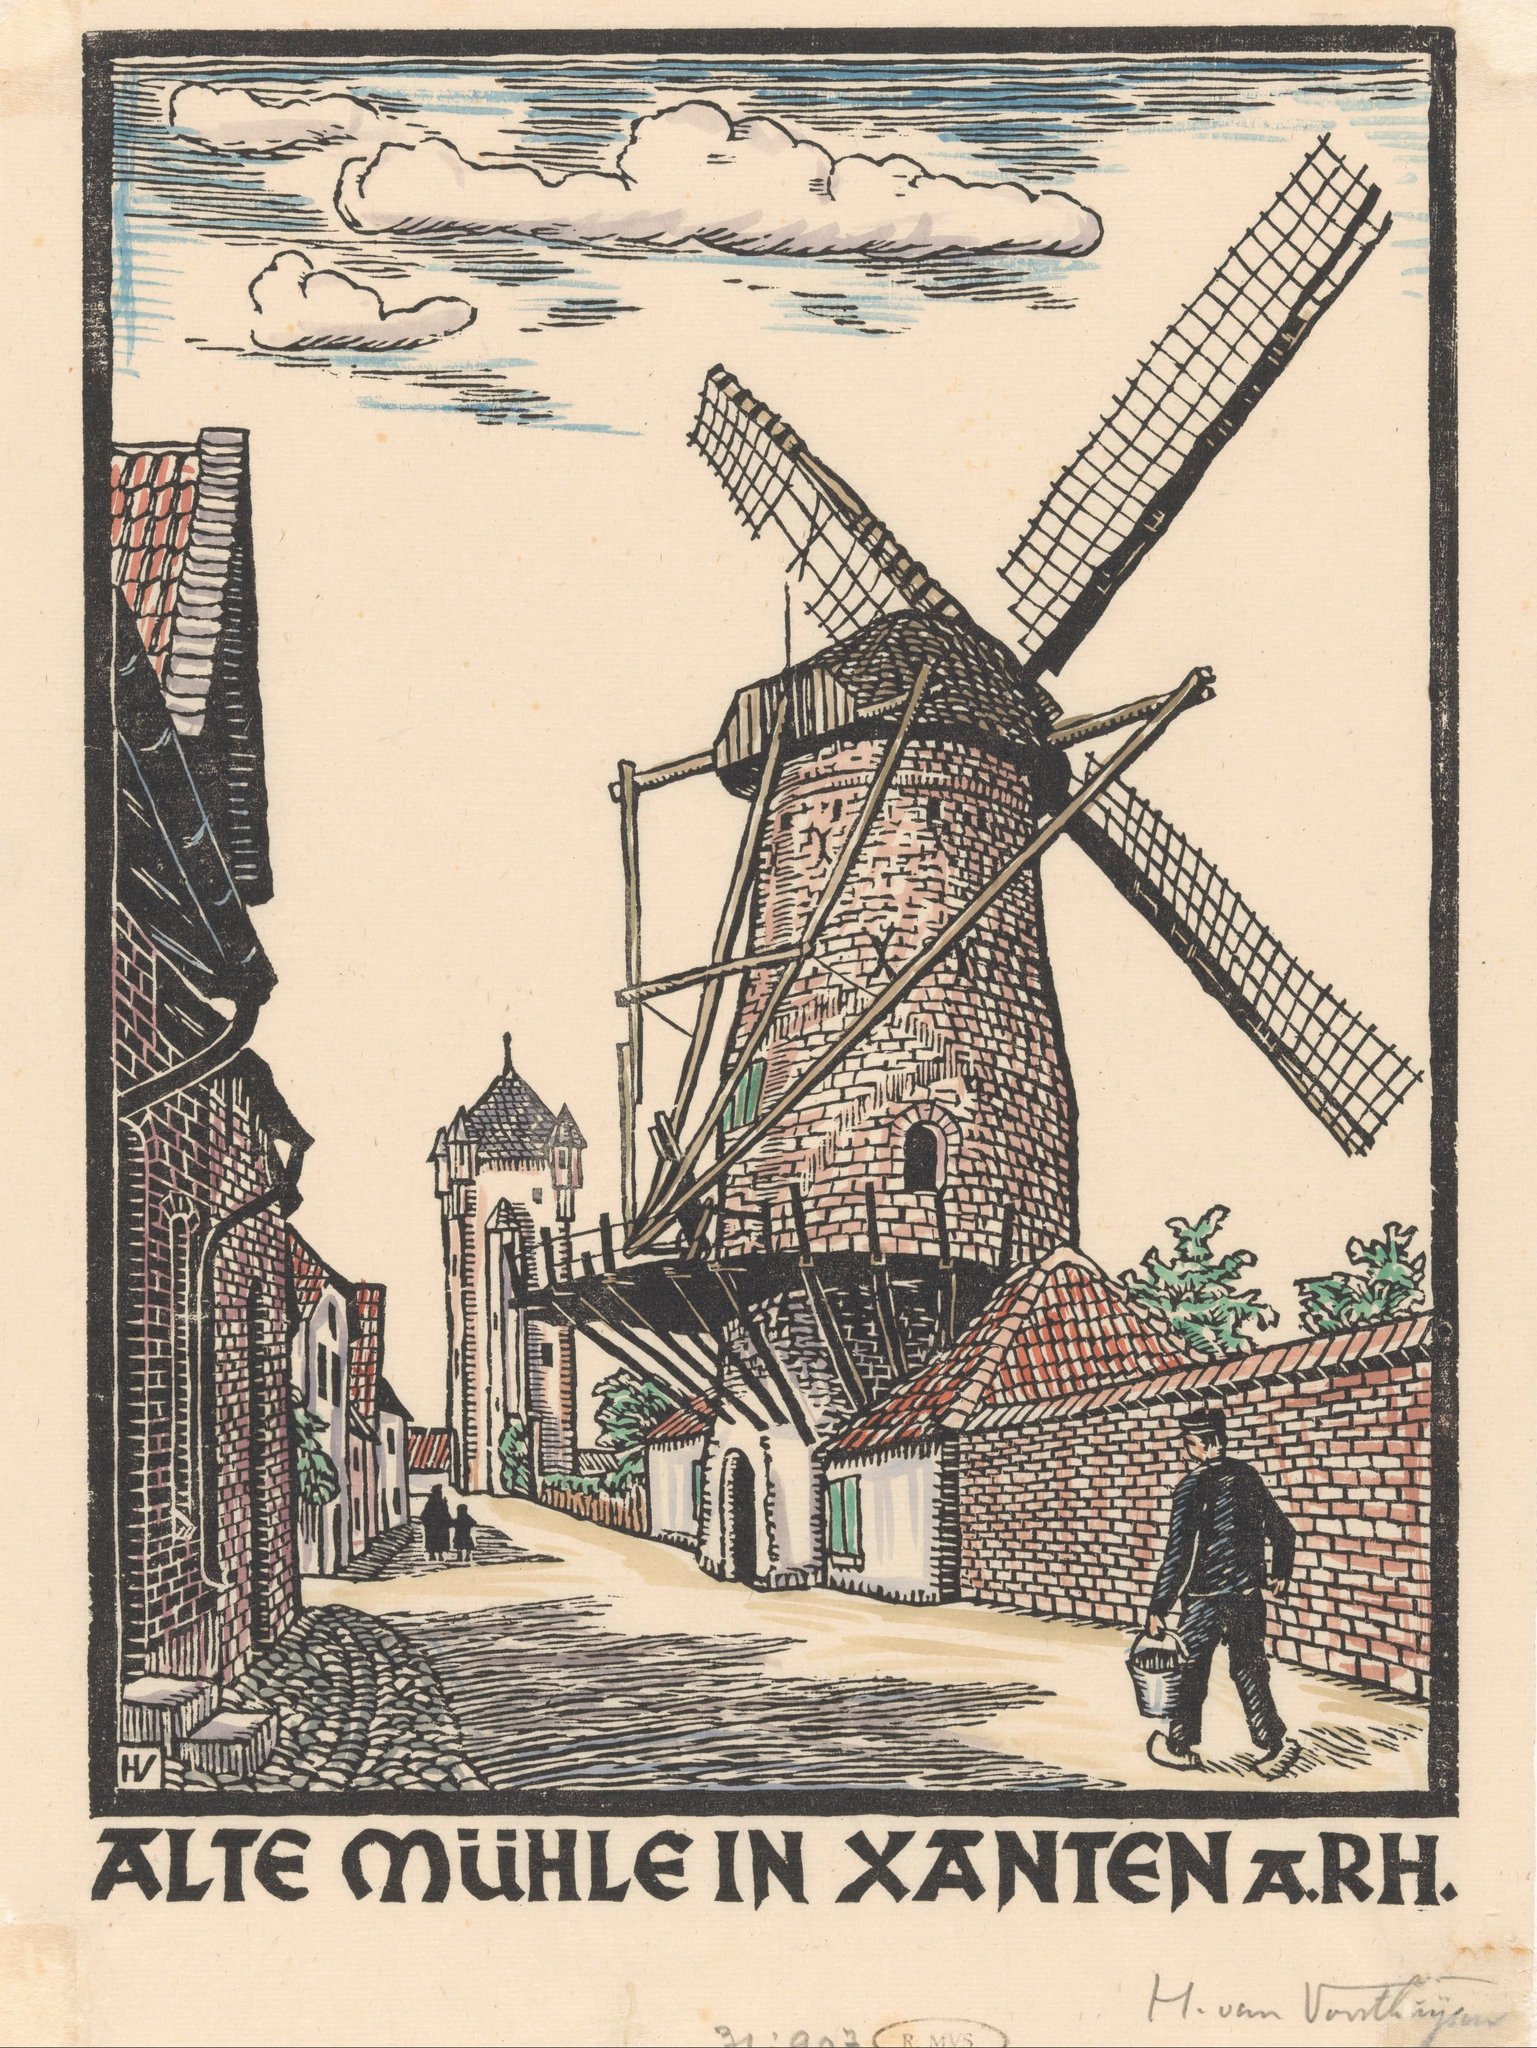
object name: print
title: Molen in Xanten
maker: henriëtte van hove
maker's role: print maker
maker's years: 1861-1918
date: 1871-1918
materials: paper, watercolor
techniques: hand coloring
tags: village street, windmill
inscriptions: collector's mark: Lugt 2228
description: Molen aan een straat. Rechts loopt een man met een emmer. Op de achtergrond een toren.